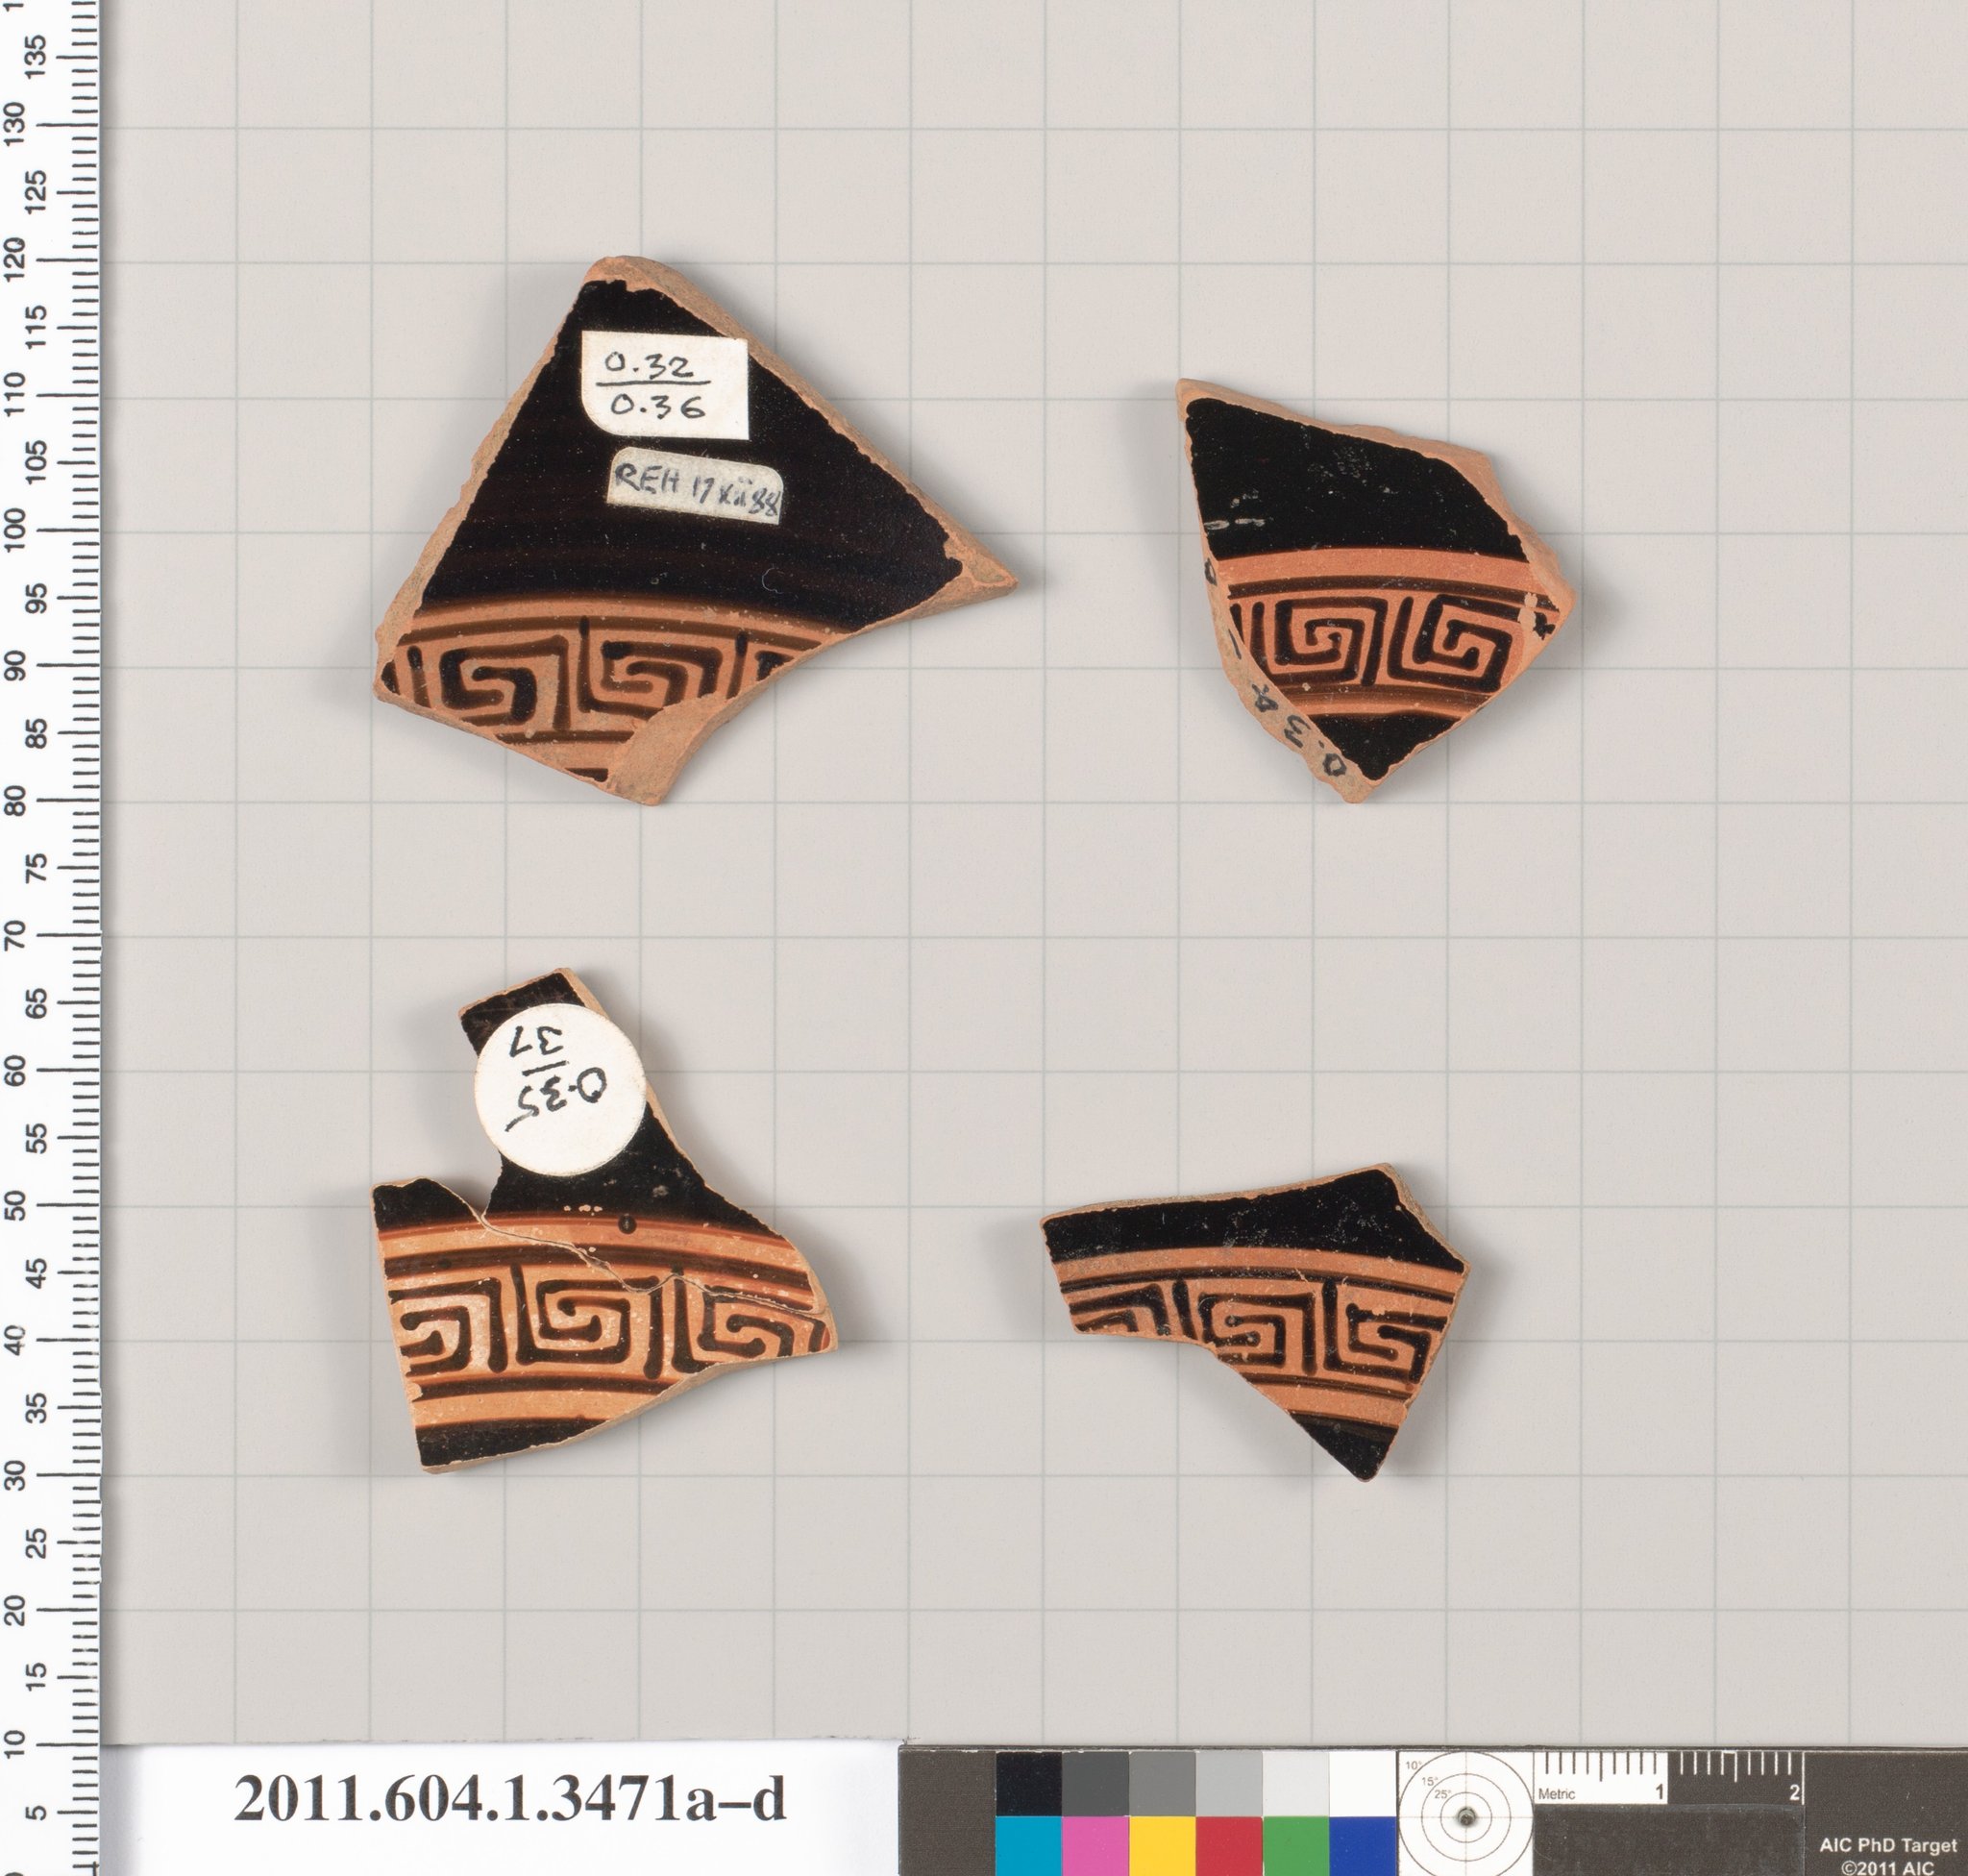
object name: kylix fragment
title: Terracotta fragments of kylikes (drinking cups)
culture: greek, attic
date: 500-475 BCE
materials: terracotta